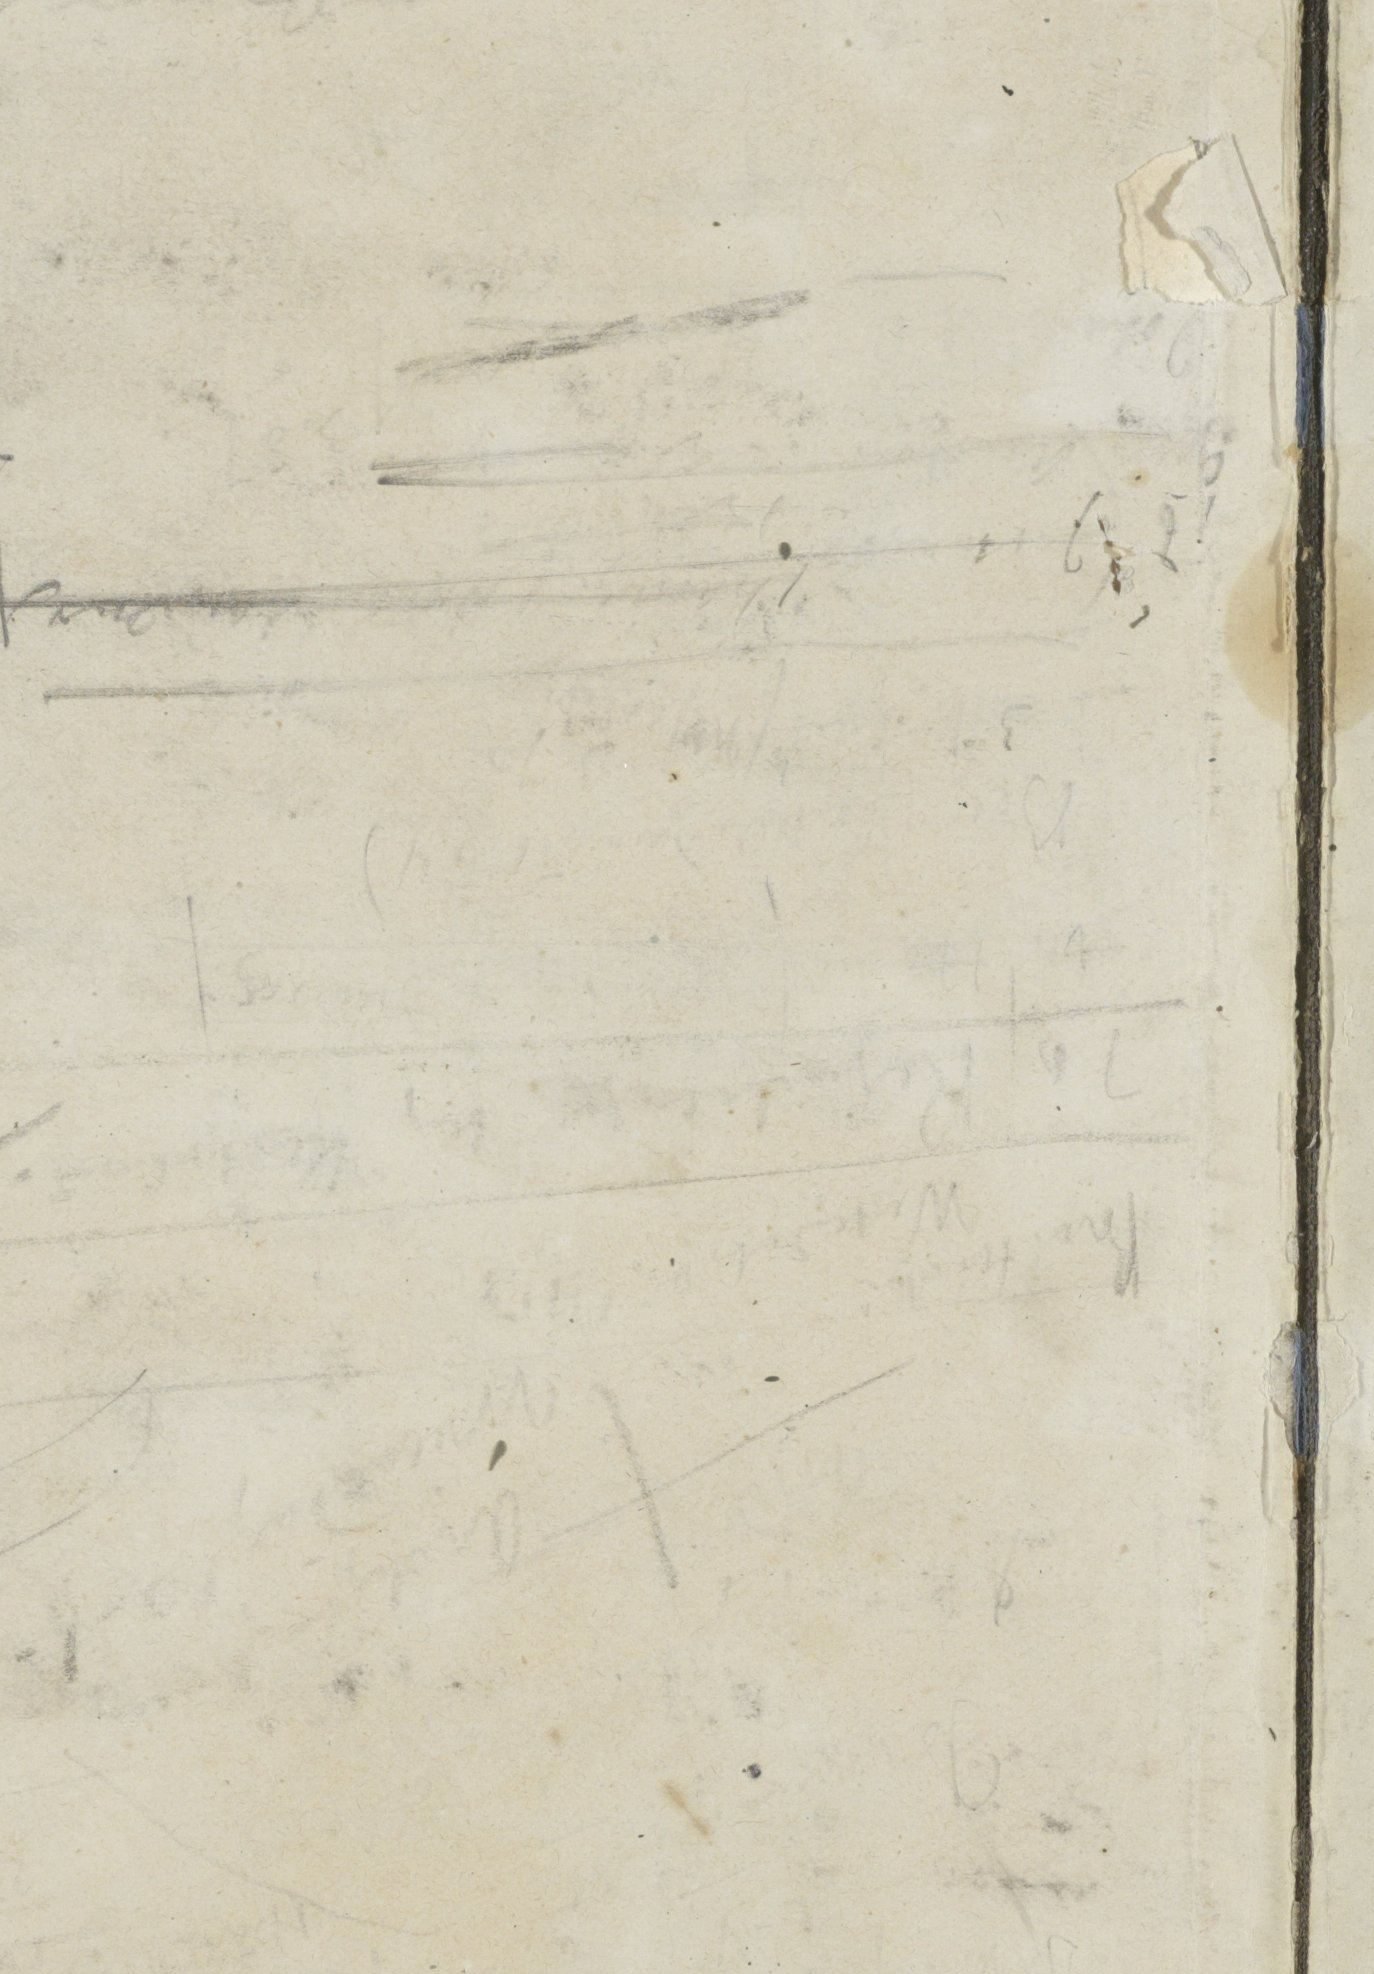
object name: sketchbook leaf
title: Annotaties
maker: george hendrik breitner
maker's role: draughtsman, painter, print maker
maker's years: 1857-1923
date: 1895-1898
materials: paper, pencil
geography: amsterdam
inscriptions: annotation: ‘[...]’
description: Pagina 41 uit een schetsboek met 20 bladen.